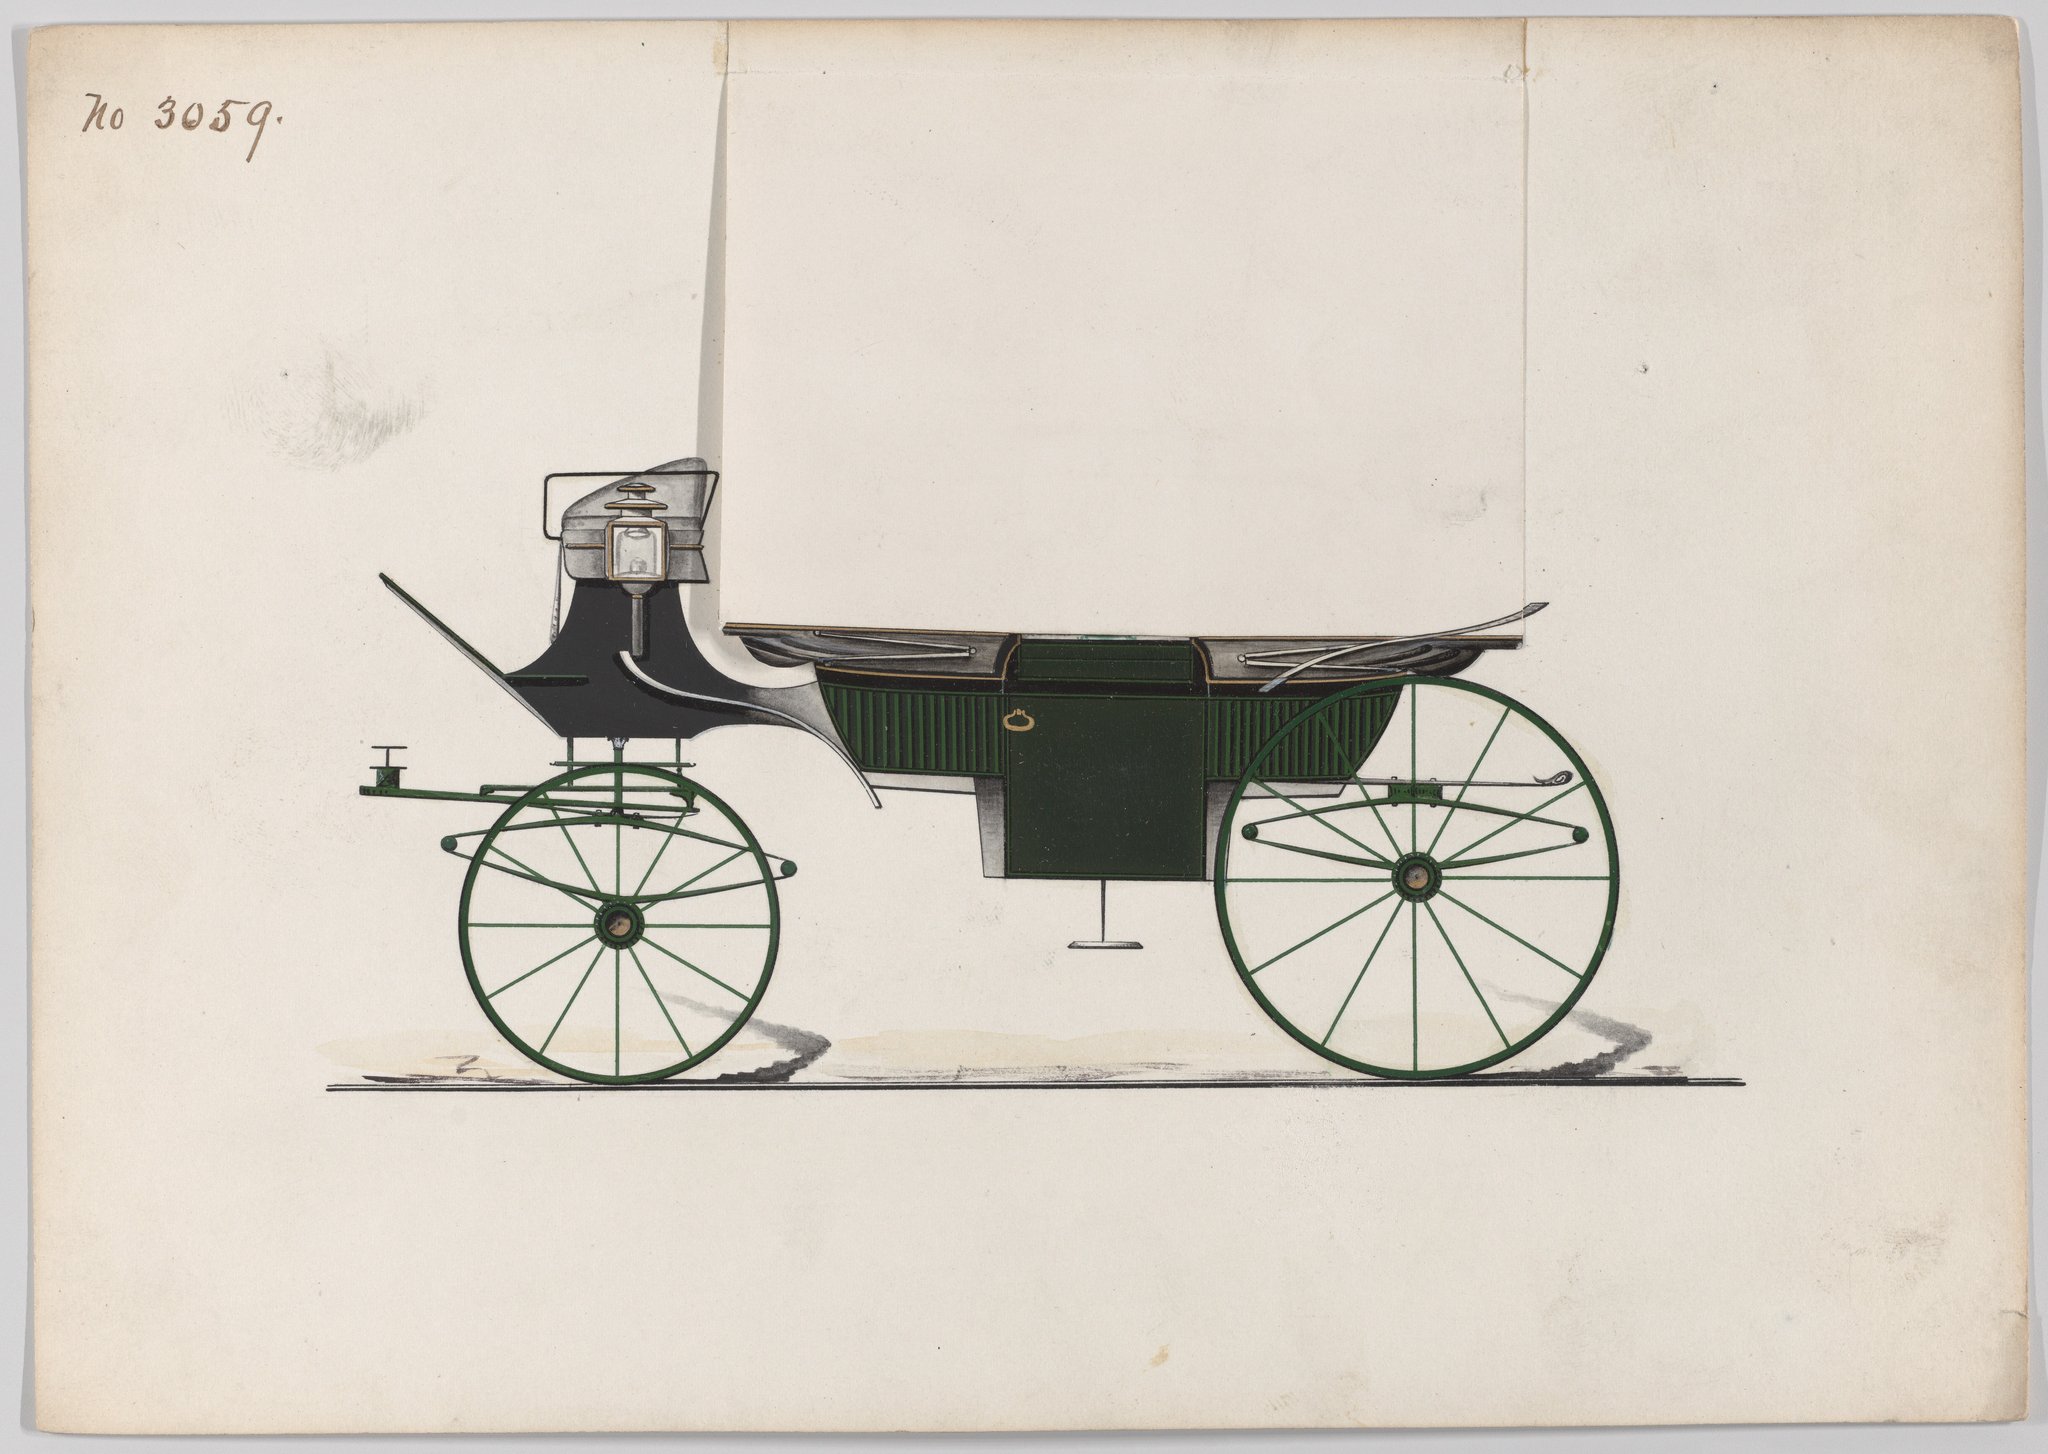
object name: drawing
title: Design for Landau, No. 3059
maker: brewster & co.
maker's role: manufacturer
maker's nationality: american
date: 1874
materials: ink, watercolor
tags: carriages